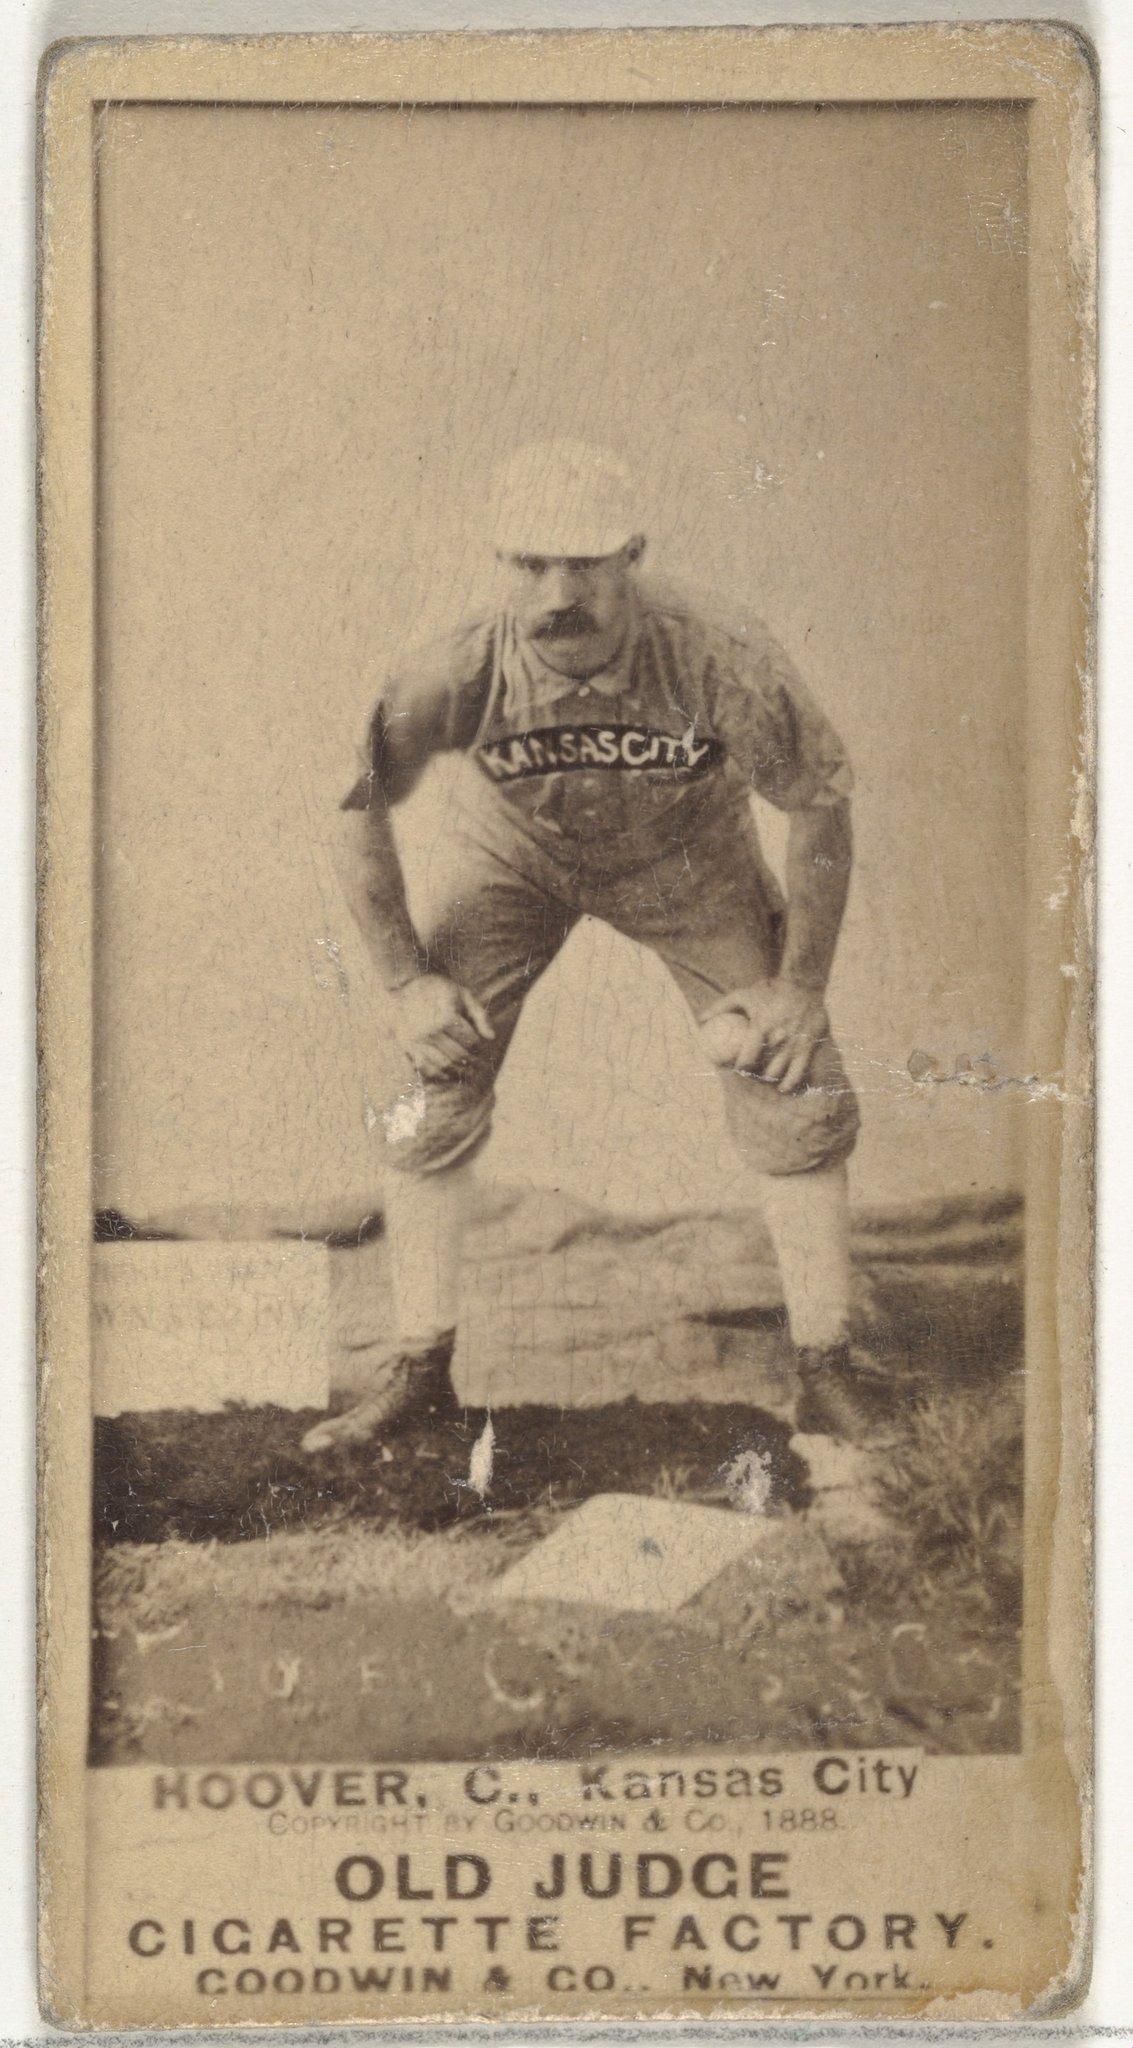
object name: baseball card, photograph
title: Charles E. "Charlie" Hoover, Catcher, Kansas City Cowboys, from the Old Judge series (N172) for Old Judge Cigarettes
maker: goodwin & company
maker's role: publisher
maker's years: 1850-1950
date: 1888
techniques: albumen silver print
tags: men,portraits,baseball,athletes